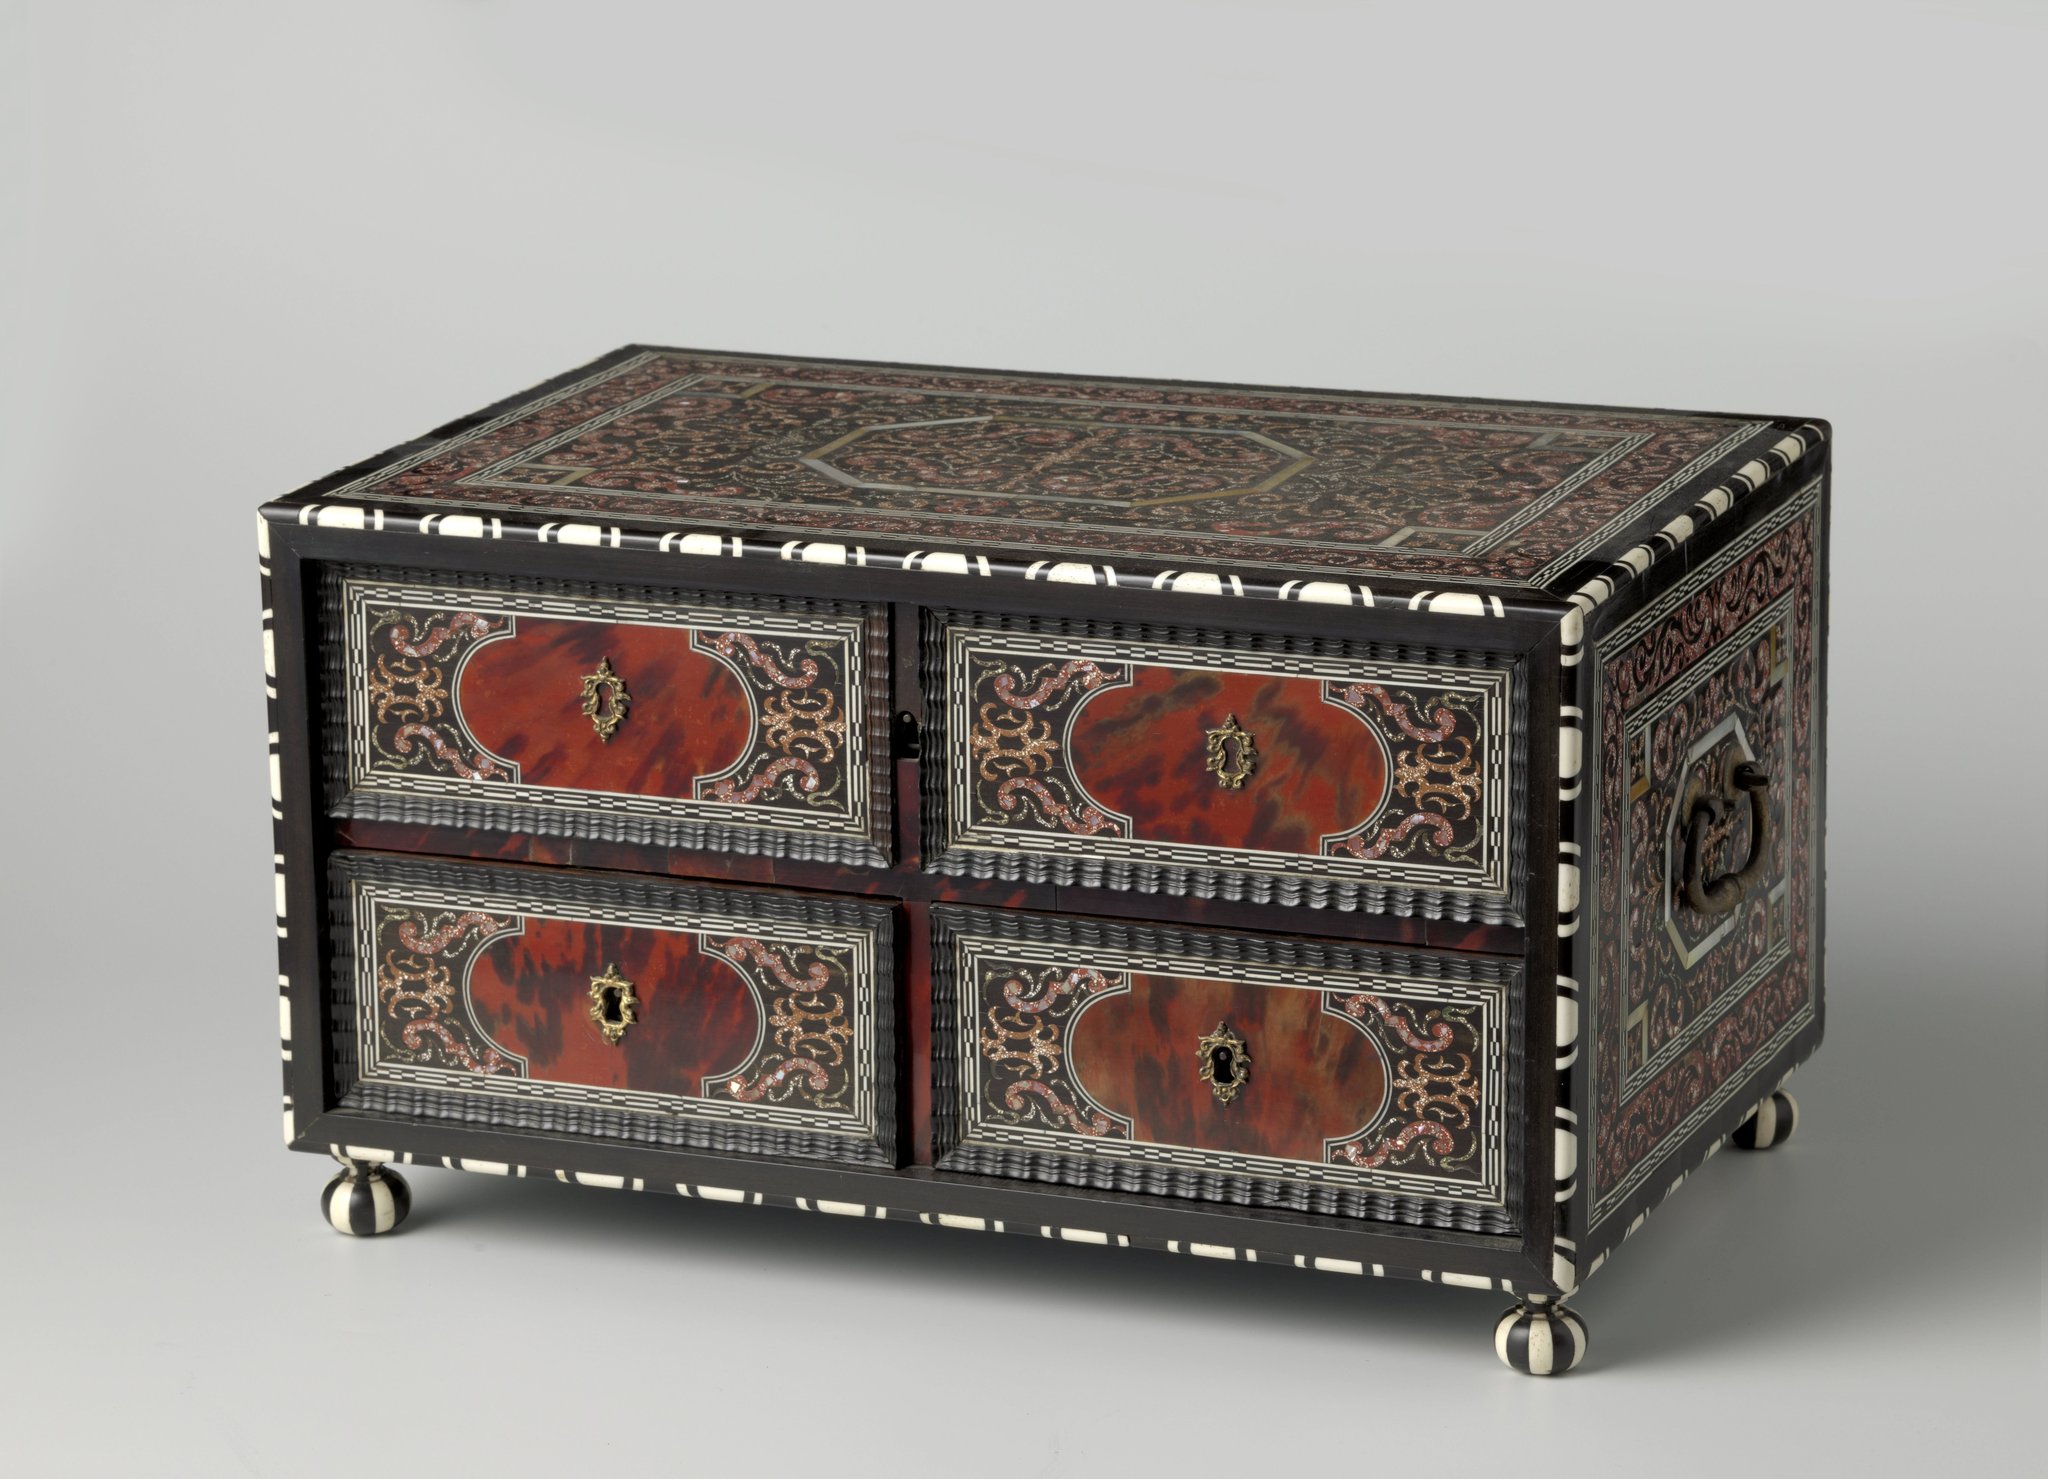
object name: chest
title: Kist van ebbenhout met vier laden, versierd met schildpad, been, parelmoer en diverse houtsoorten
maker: Anonymous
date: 1400-1950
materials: bone, copper, wood, ivory, lacquer, mother of pearl, shell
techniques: gilding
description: Kist van ebbenhout met drie laden waarvan er één is verdeeld in een aantal bakjes. Het kistje staat op drie half benen, half houten poten. Ingelegd met schildpad, been, parelmoer en verschillende houtsoorten. Koperen sleutelplaten en vergulde hengsels. Opmerking: de sleutel is defect.